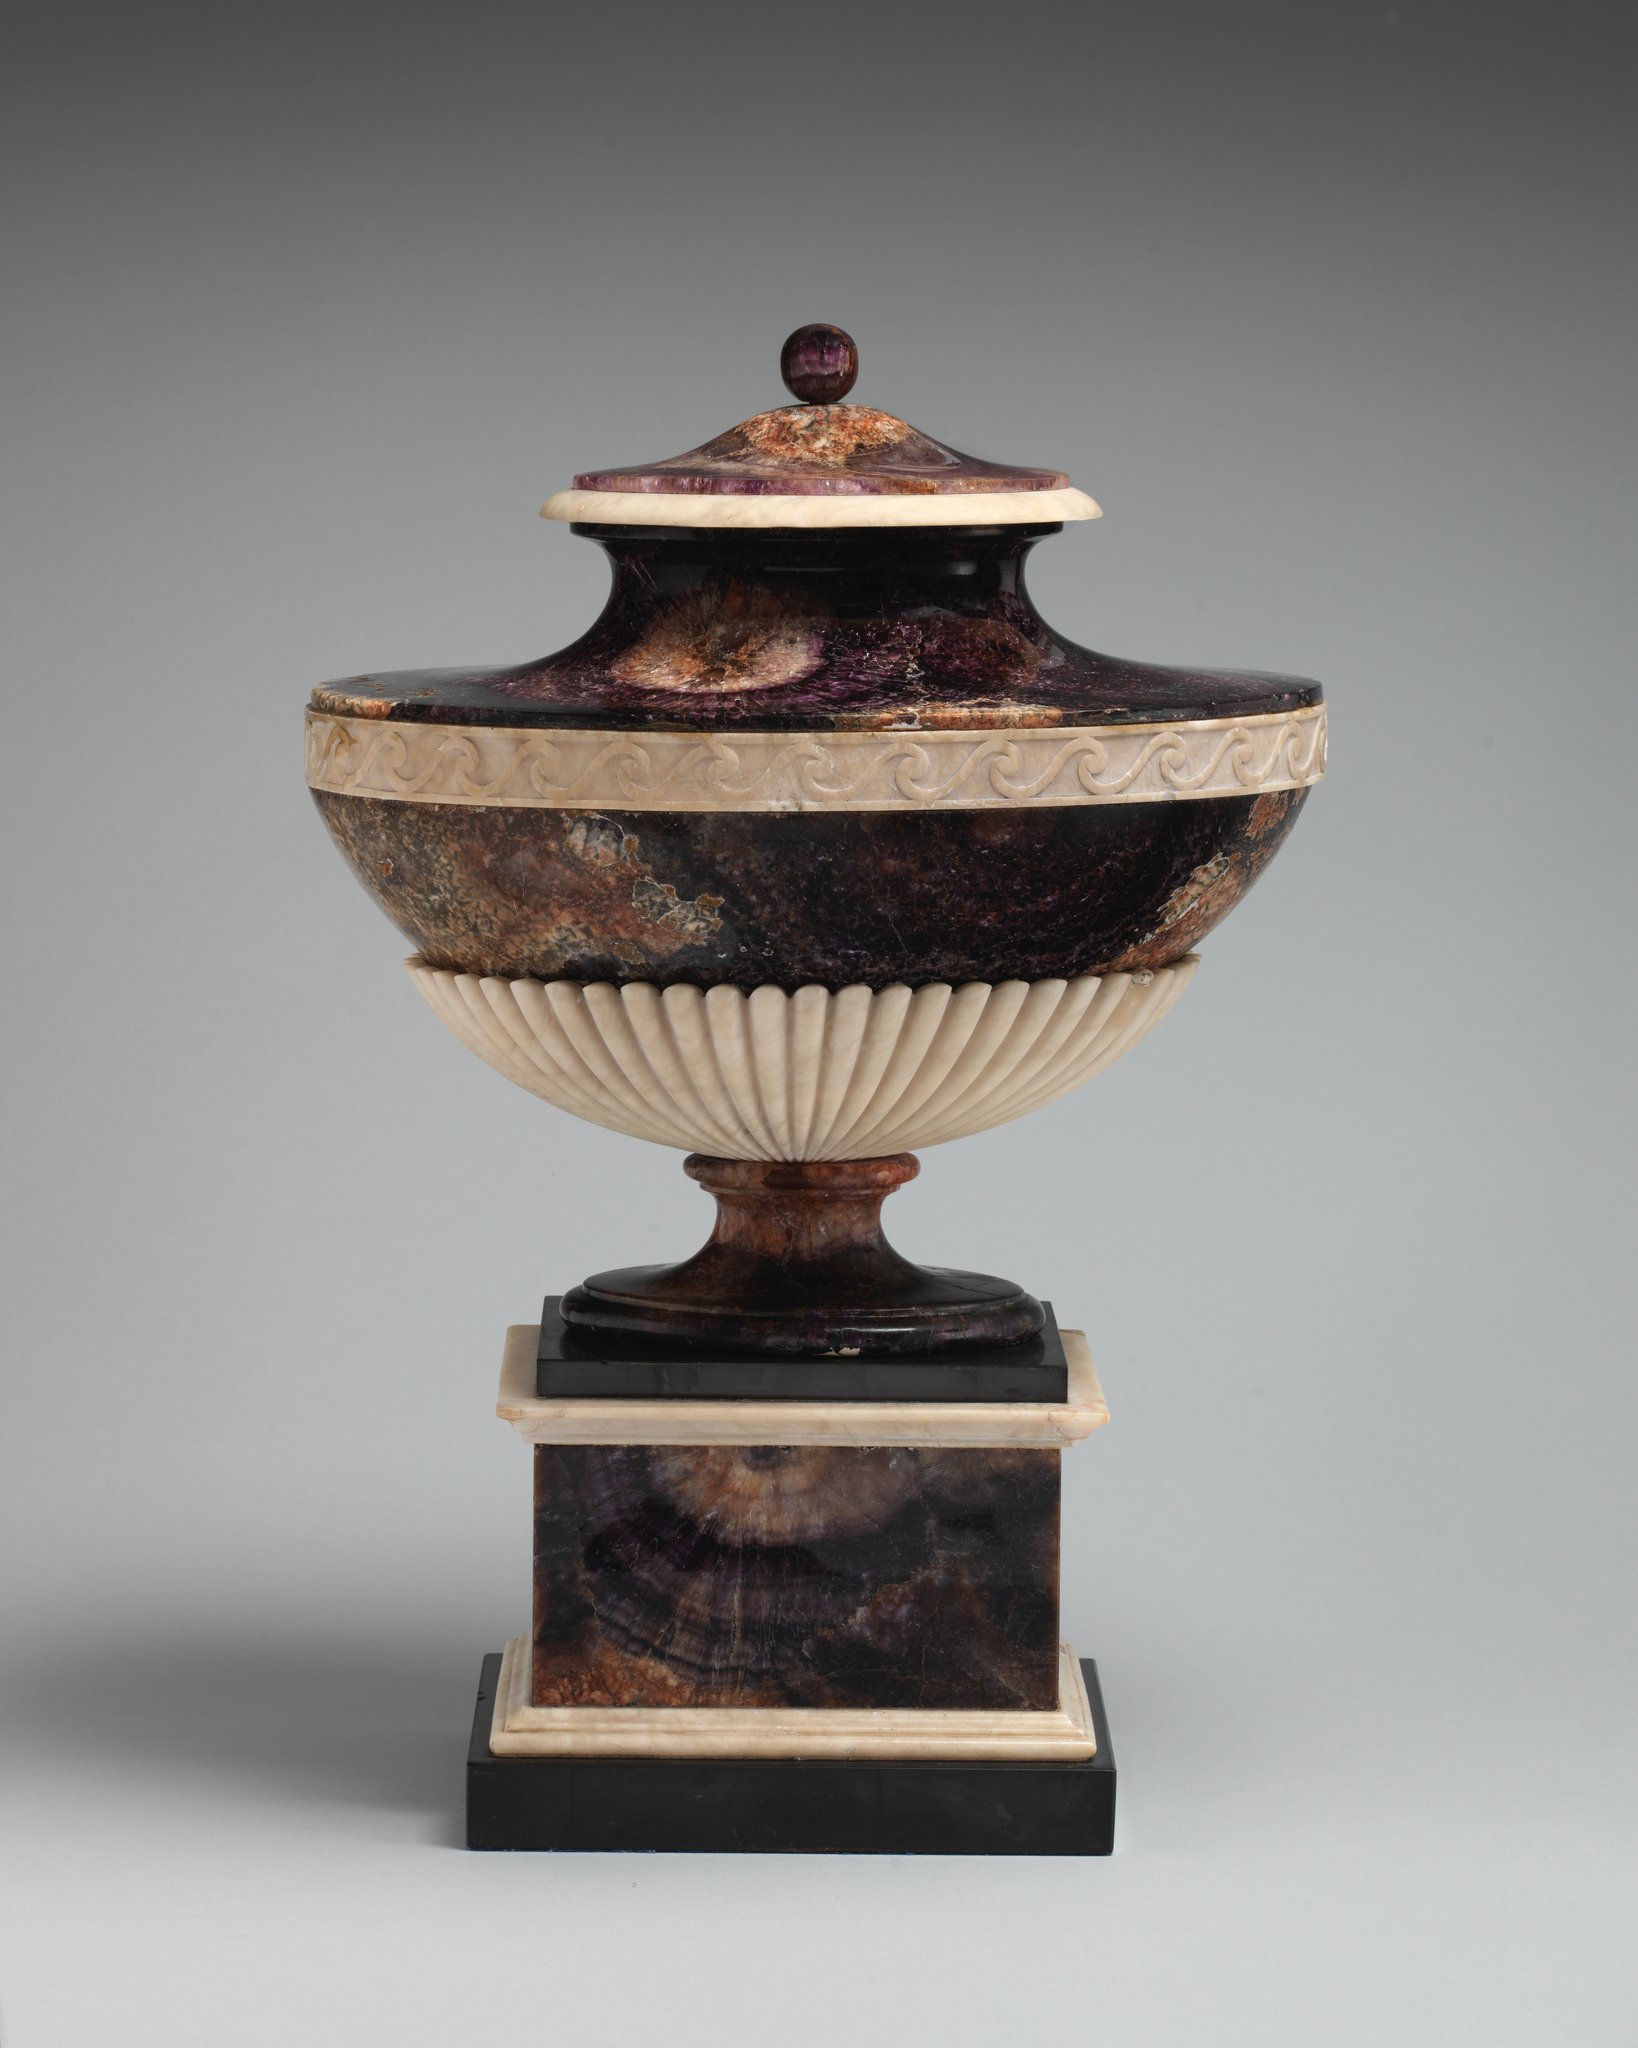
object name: urn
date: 1767-1800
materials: alabaster